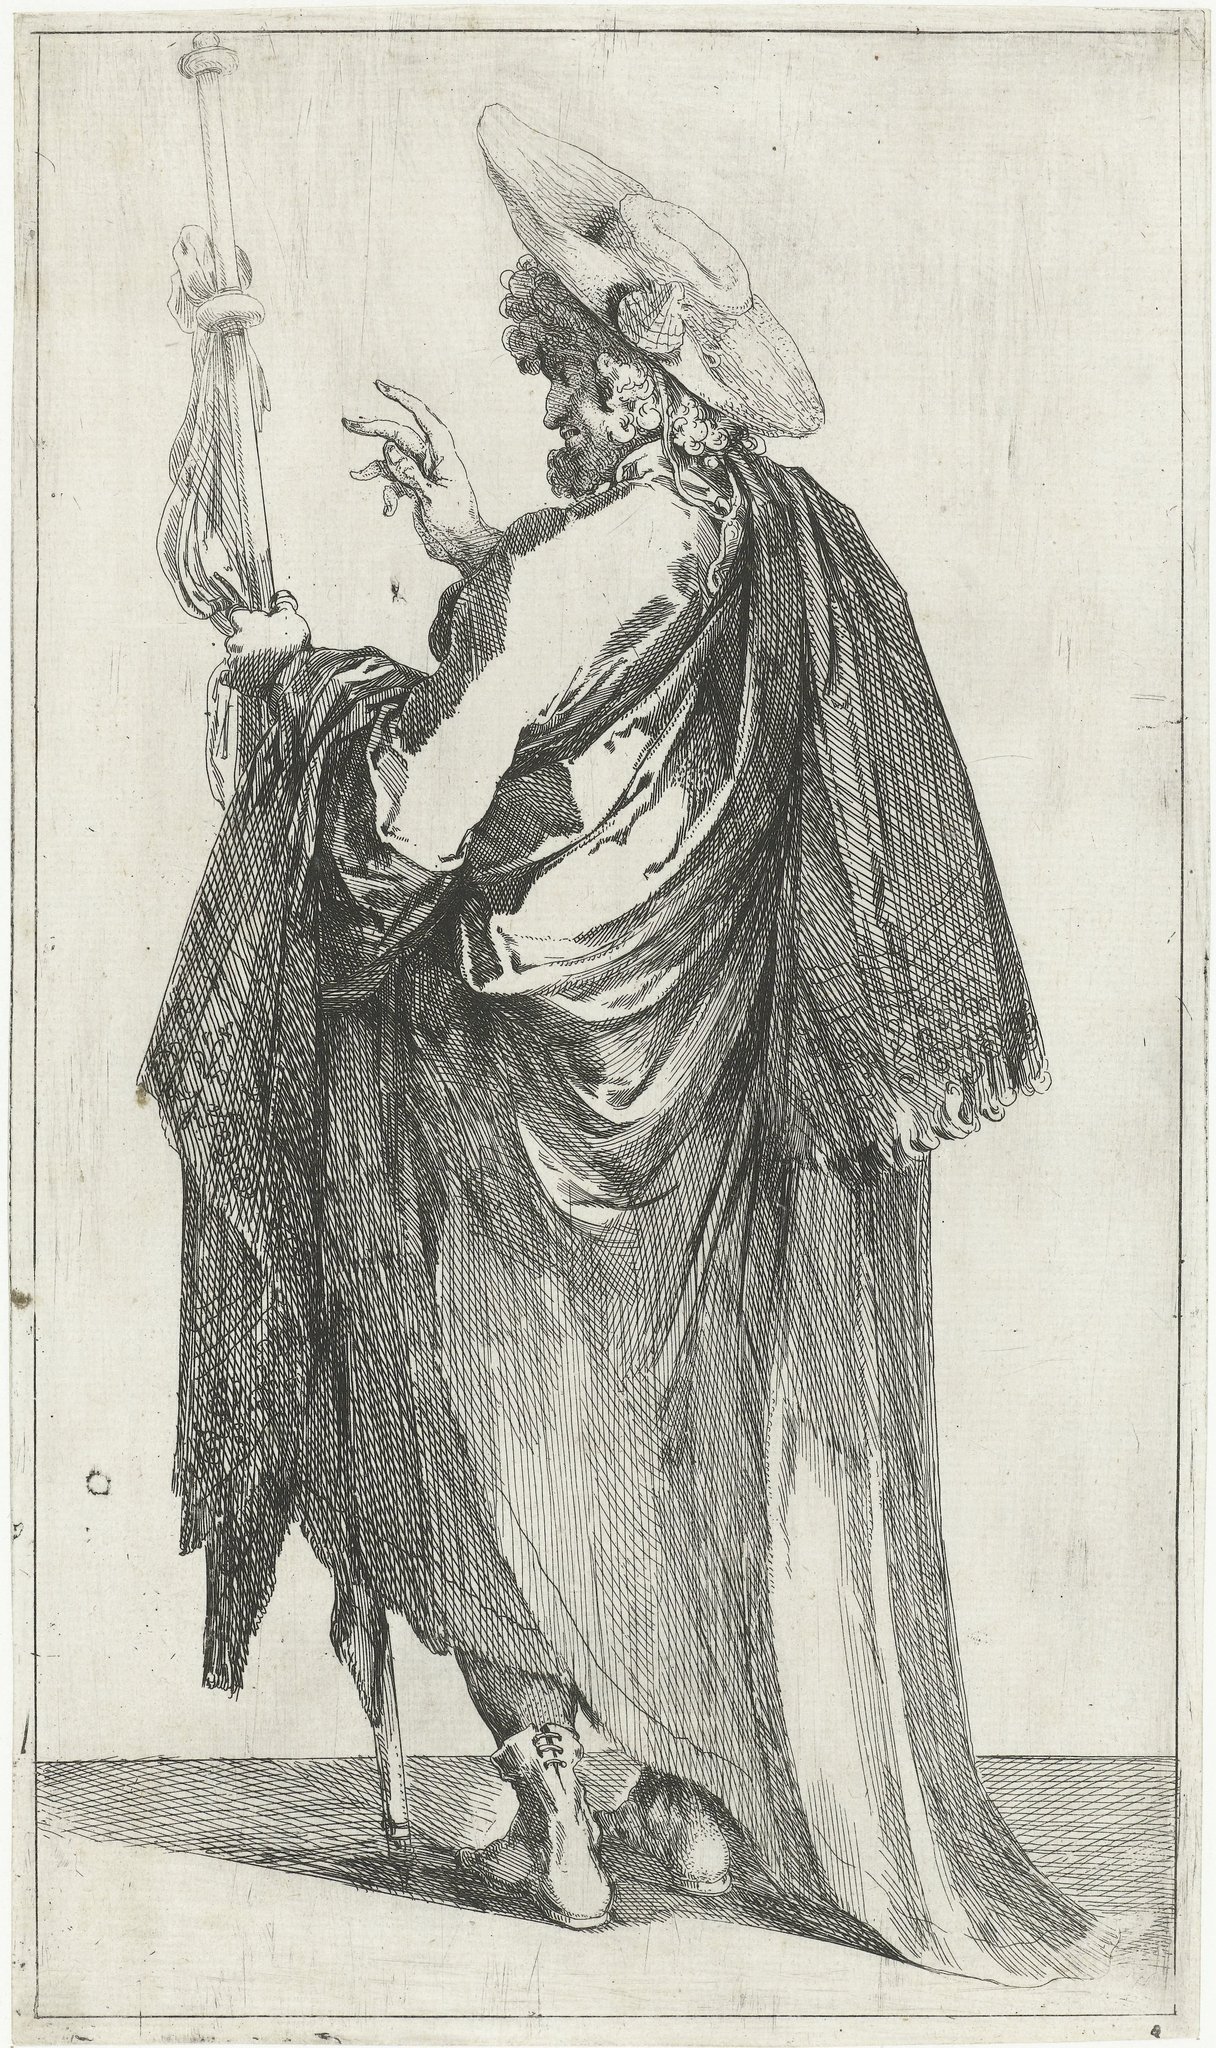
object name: print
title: Apostel Jakobus Major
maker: jacques bellange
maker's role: draughtsman, print maker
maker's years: 1575-1616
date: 1602-1616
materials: paper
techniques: etching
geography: france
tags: the apostle james the great; possible attributes: book, pilgrim's cloak, hat, shell, staff, and wallet, scroll, sword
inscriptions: collector's mark: Lugt 2228, collector's mark: Lugt 2760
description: De apostel Jakobus Major op de rug gezien, met een pelgrimshoed op en een staf in zijn hand.